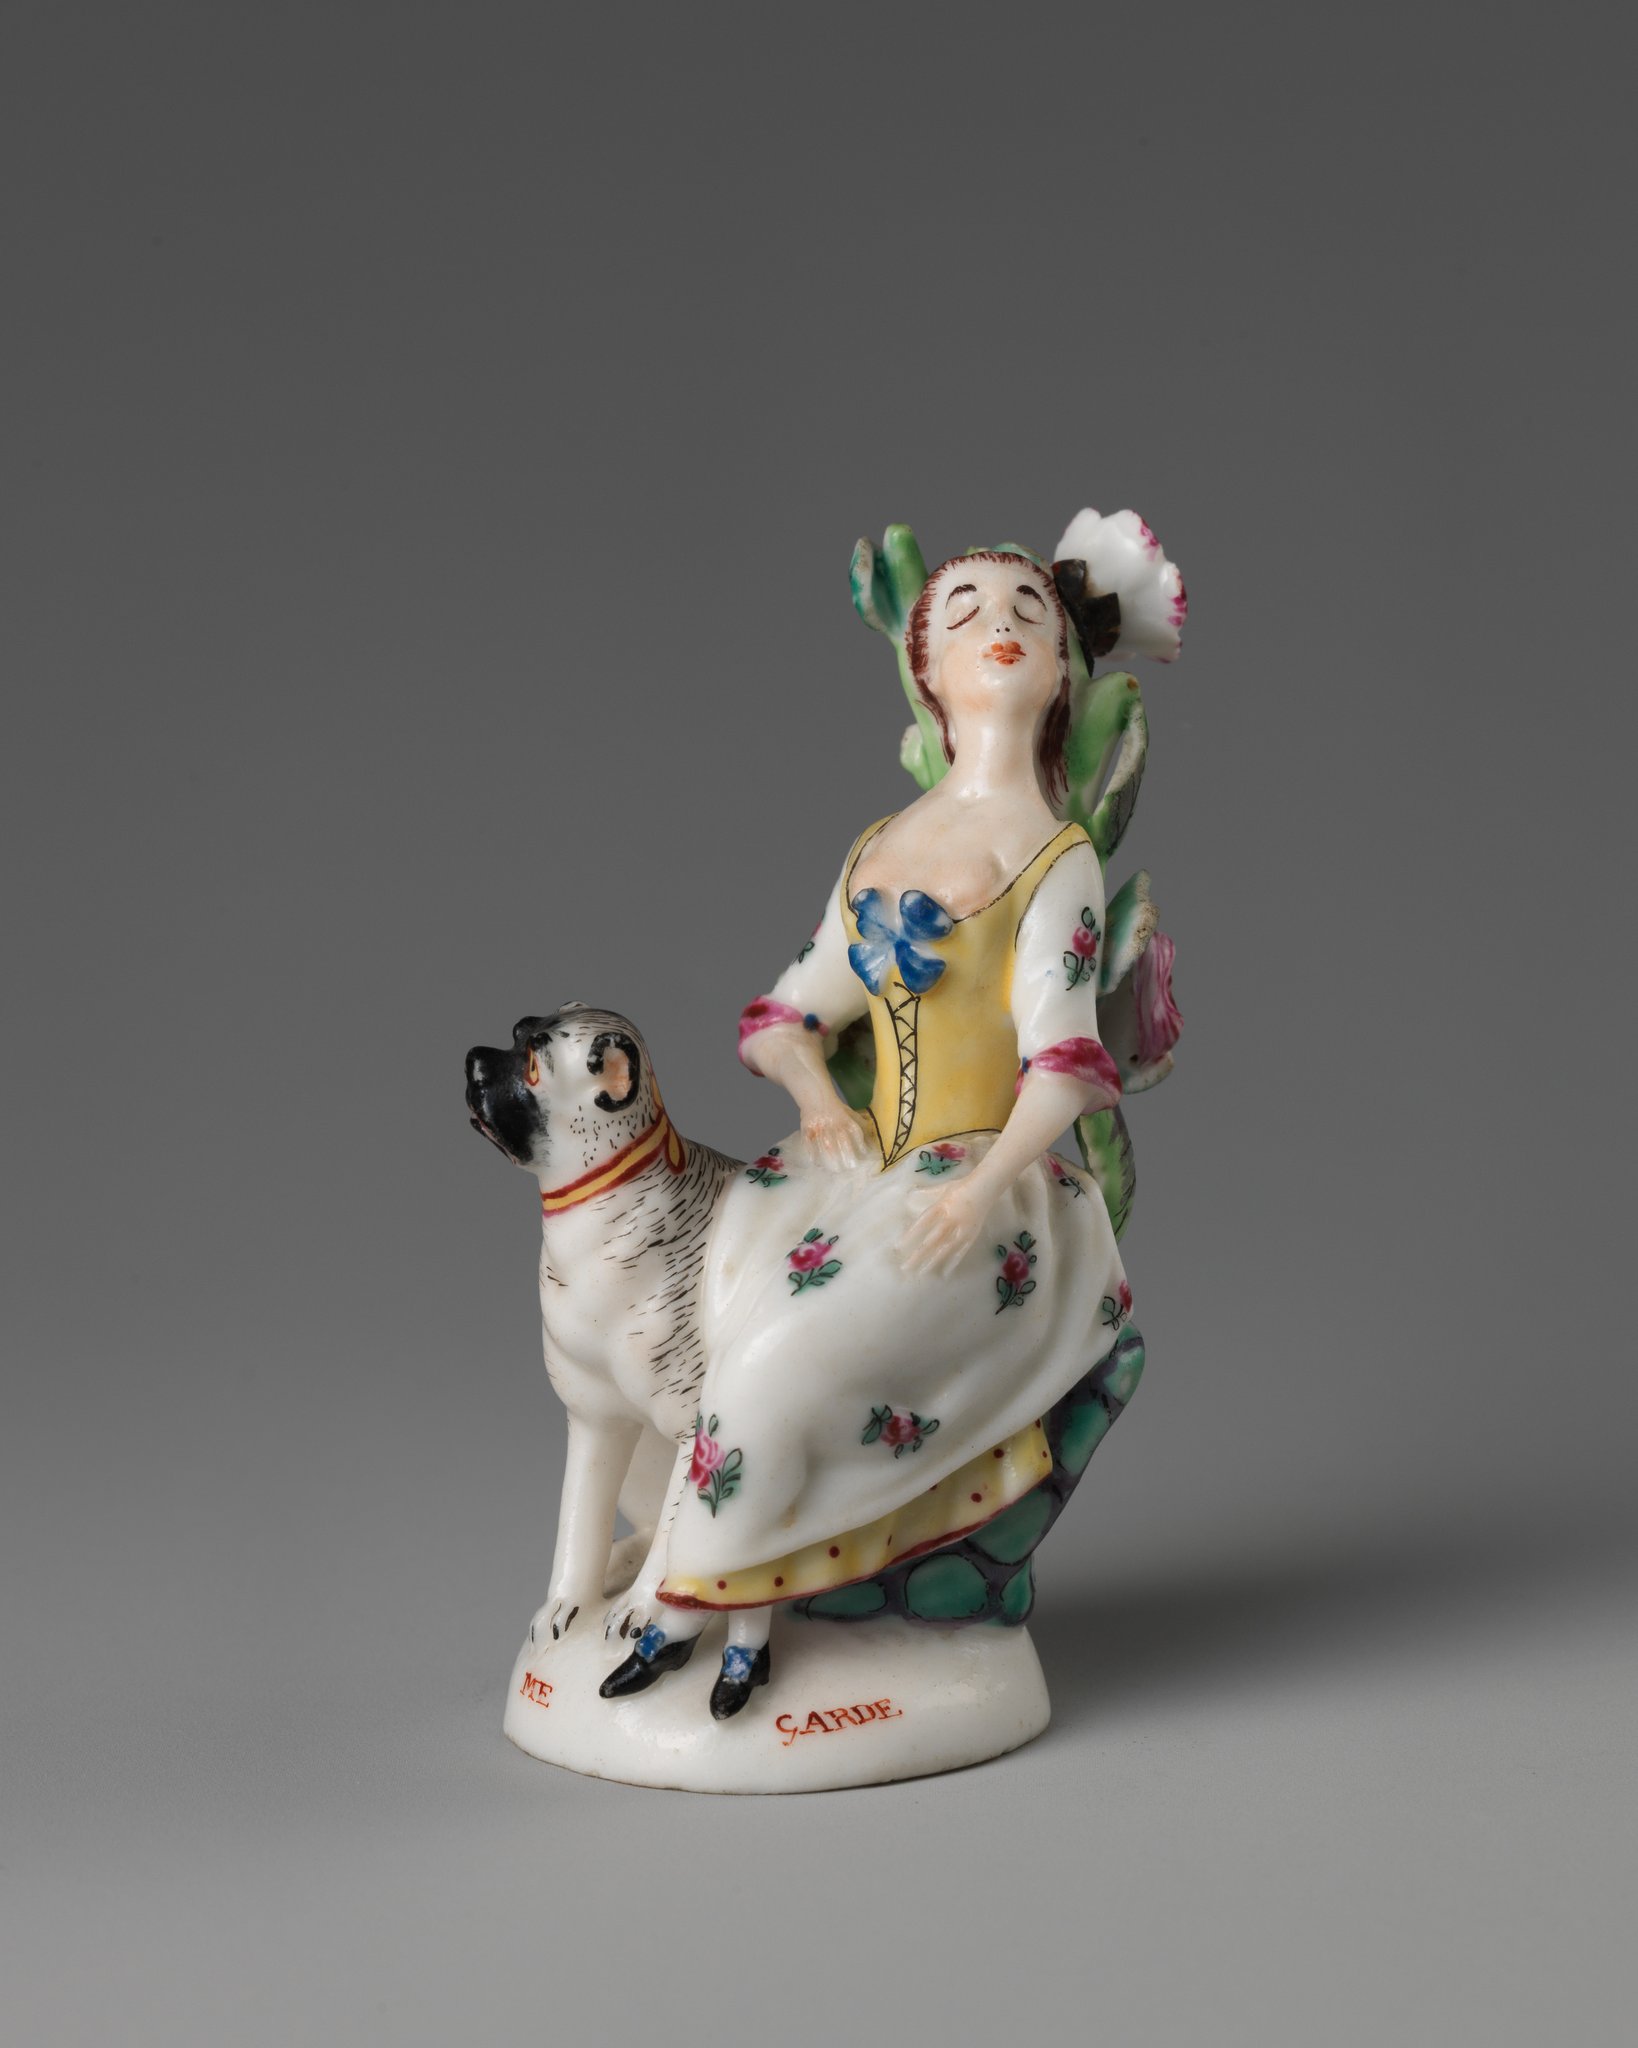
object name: toy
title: Girl with dog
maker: saint james's factory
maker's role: maker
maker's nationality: british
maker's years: 1749-1759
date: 1750-1755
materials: soft paste porcelain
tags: girls,dogs